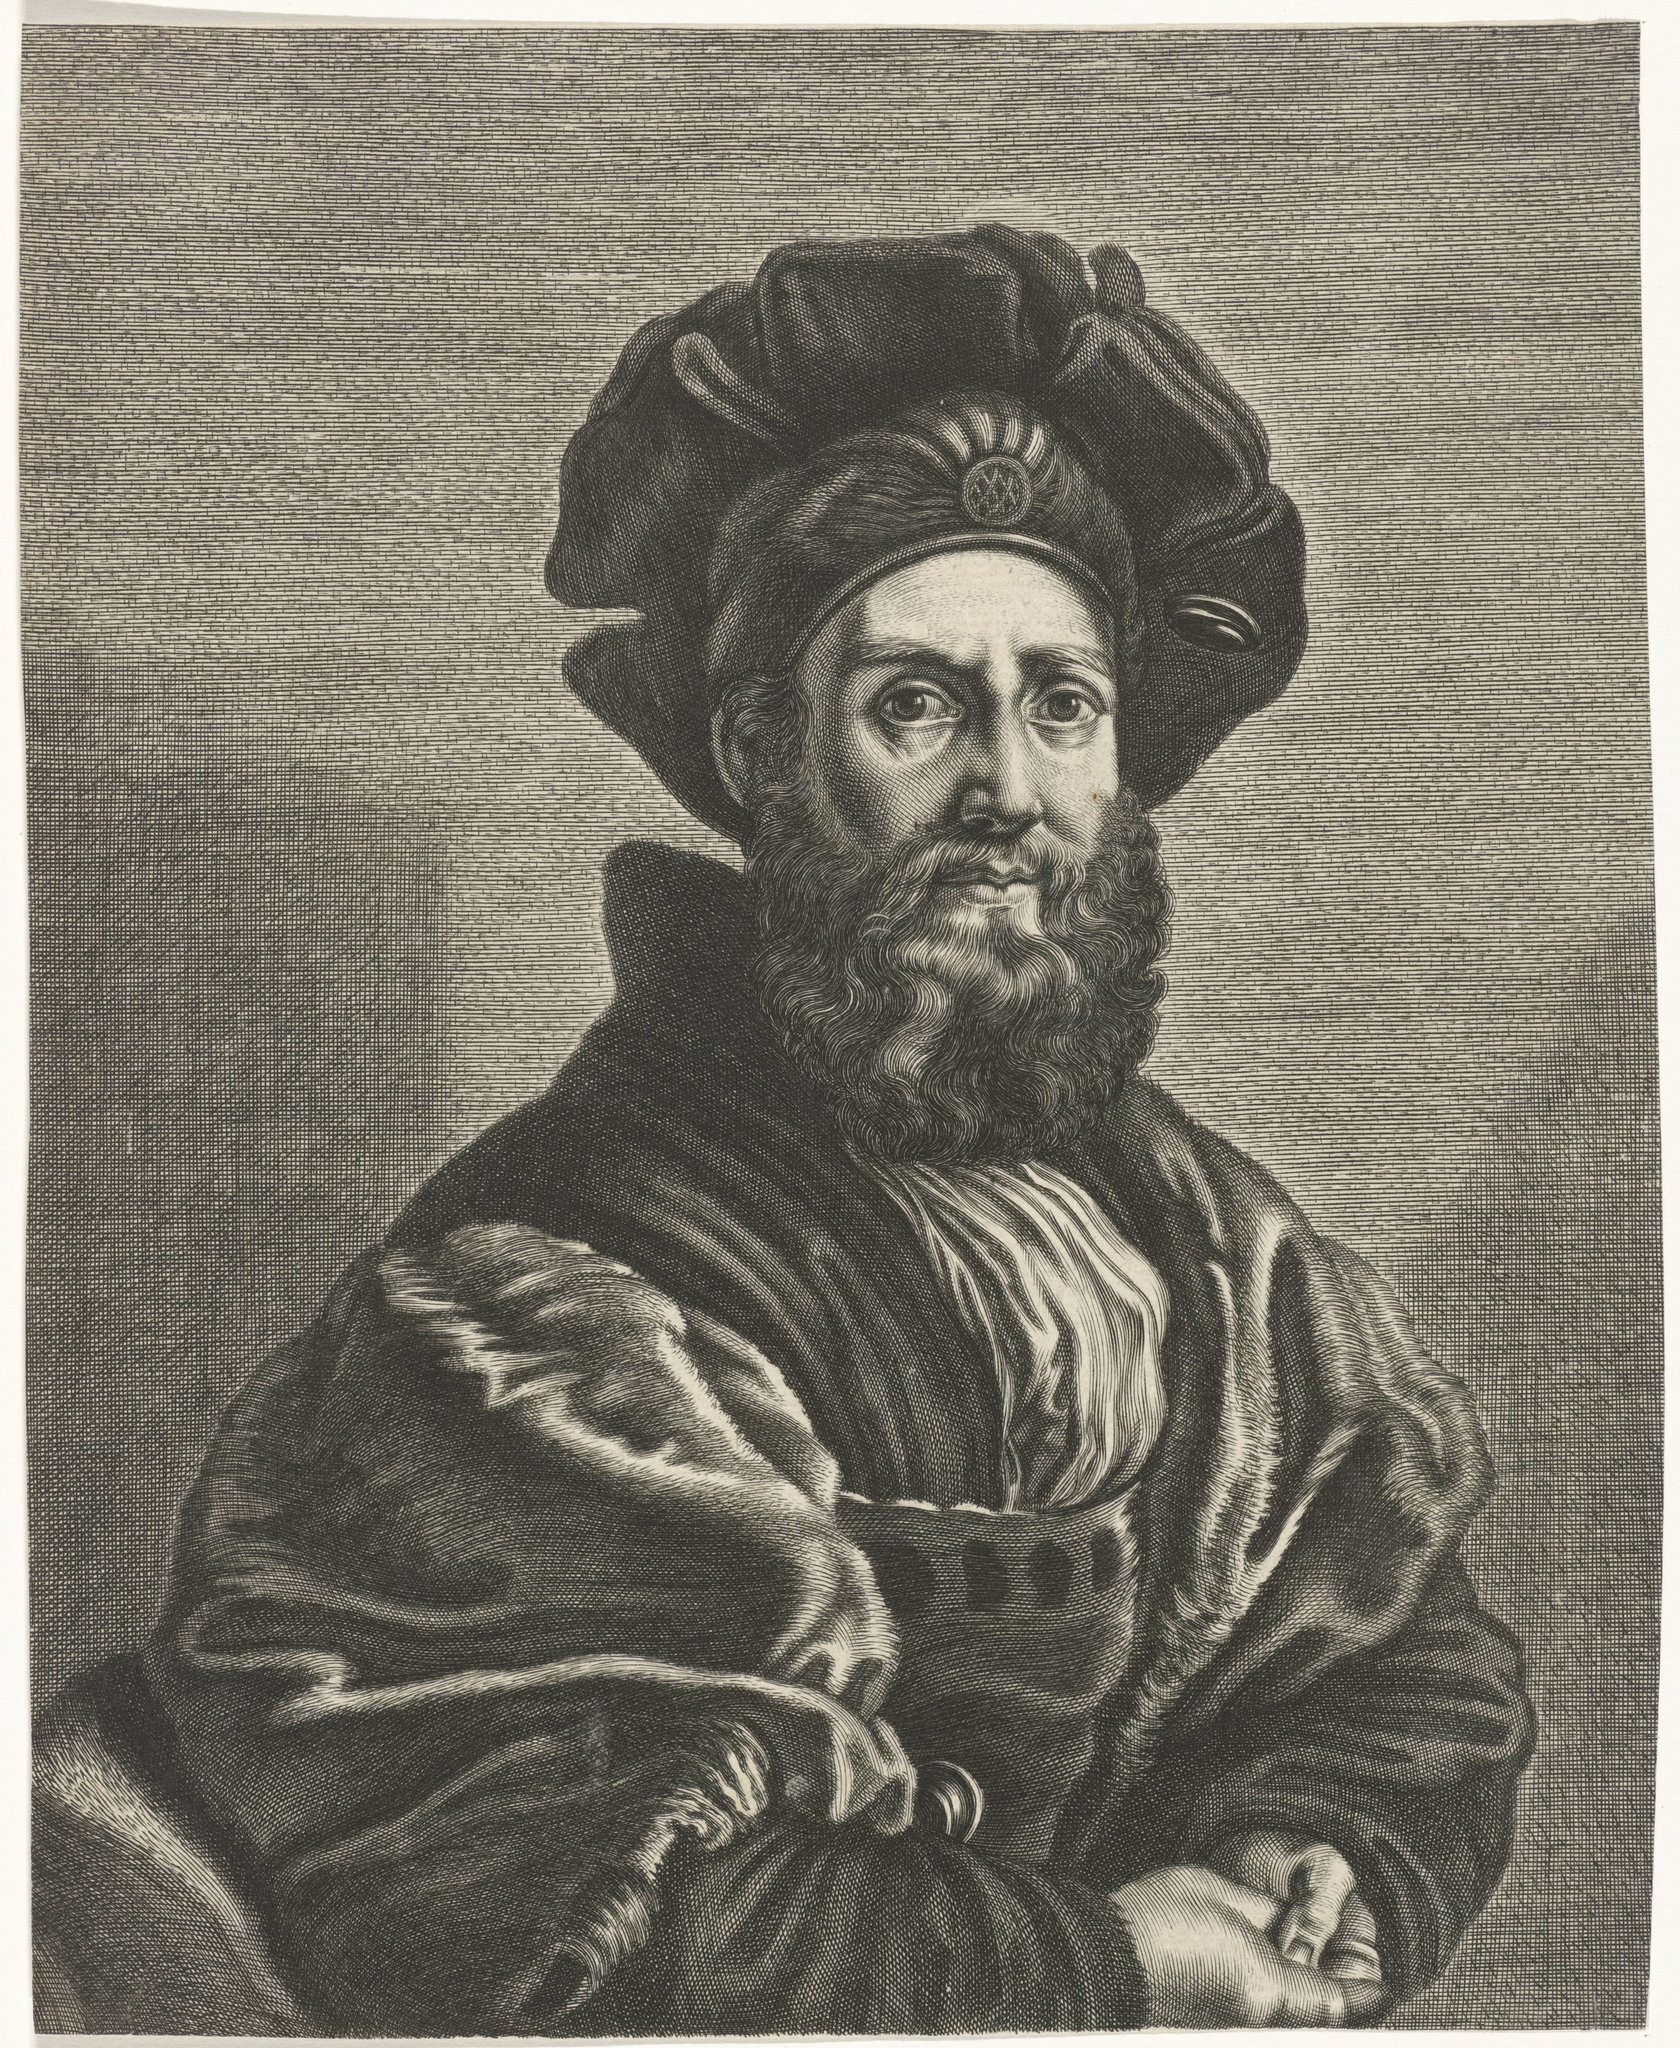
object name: print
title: Portret van Baldassare Castiglione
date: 1623-1668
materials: paper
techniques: engraving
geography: northern netherlands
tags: mantua, toledo, baldassare castiglione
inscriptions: collector's mark: Lugt 2228, inscription: ‘Balthasar Castiglione’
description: Portret van de Italiaanse dichter Baldassare Castiglione, graaf van Novellata.